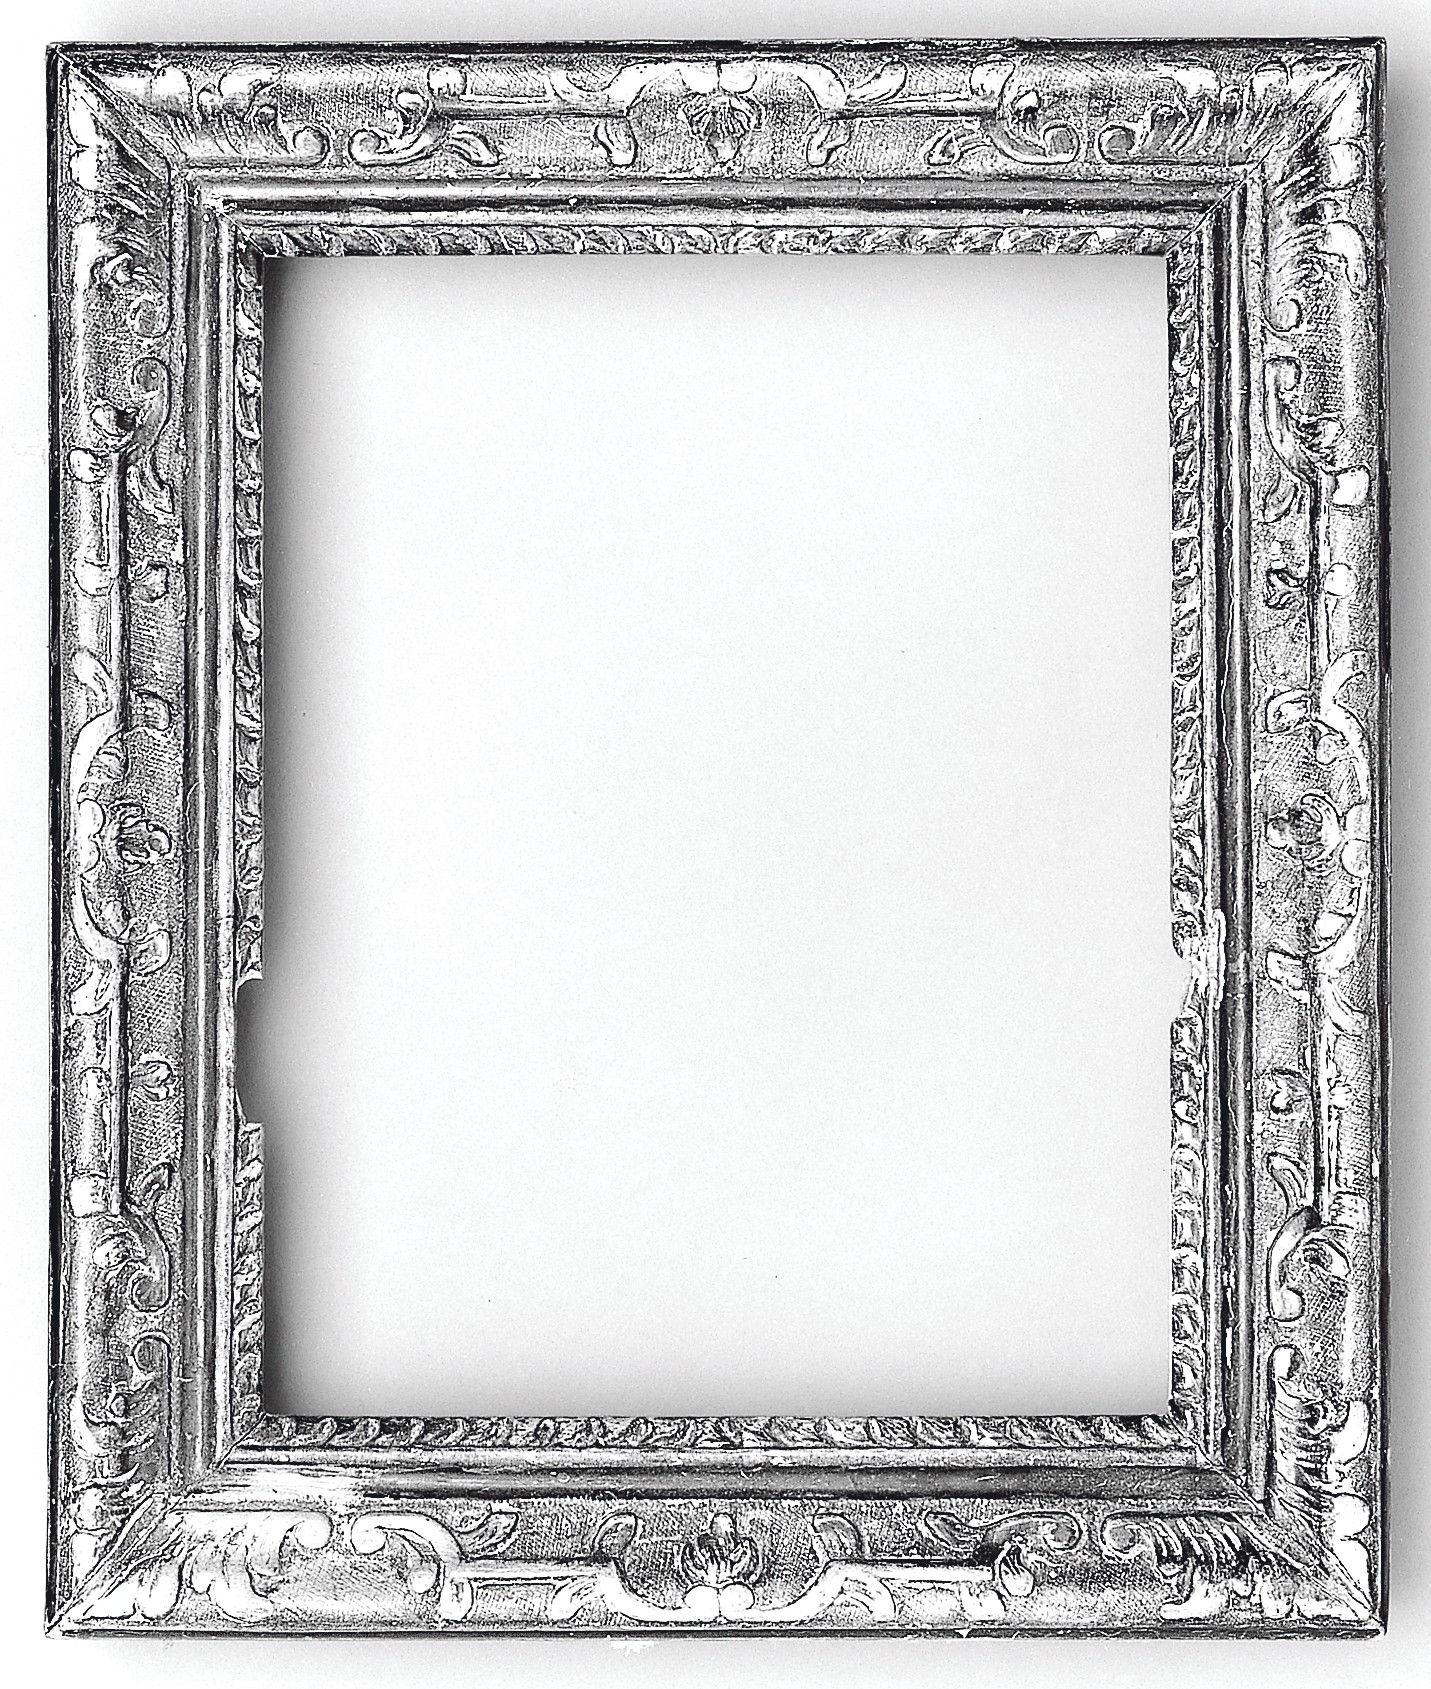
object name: frame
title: Queen Anne frame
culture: british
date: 1720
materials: wood, feather